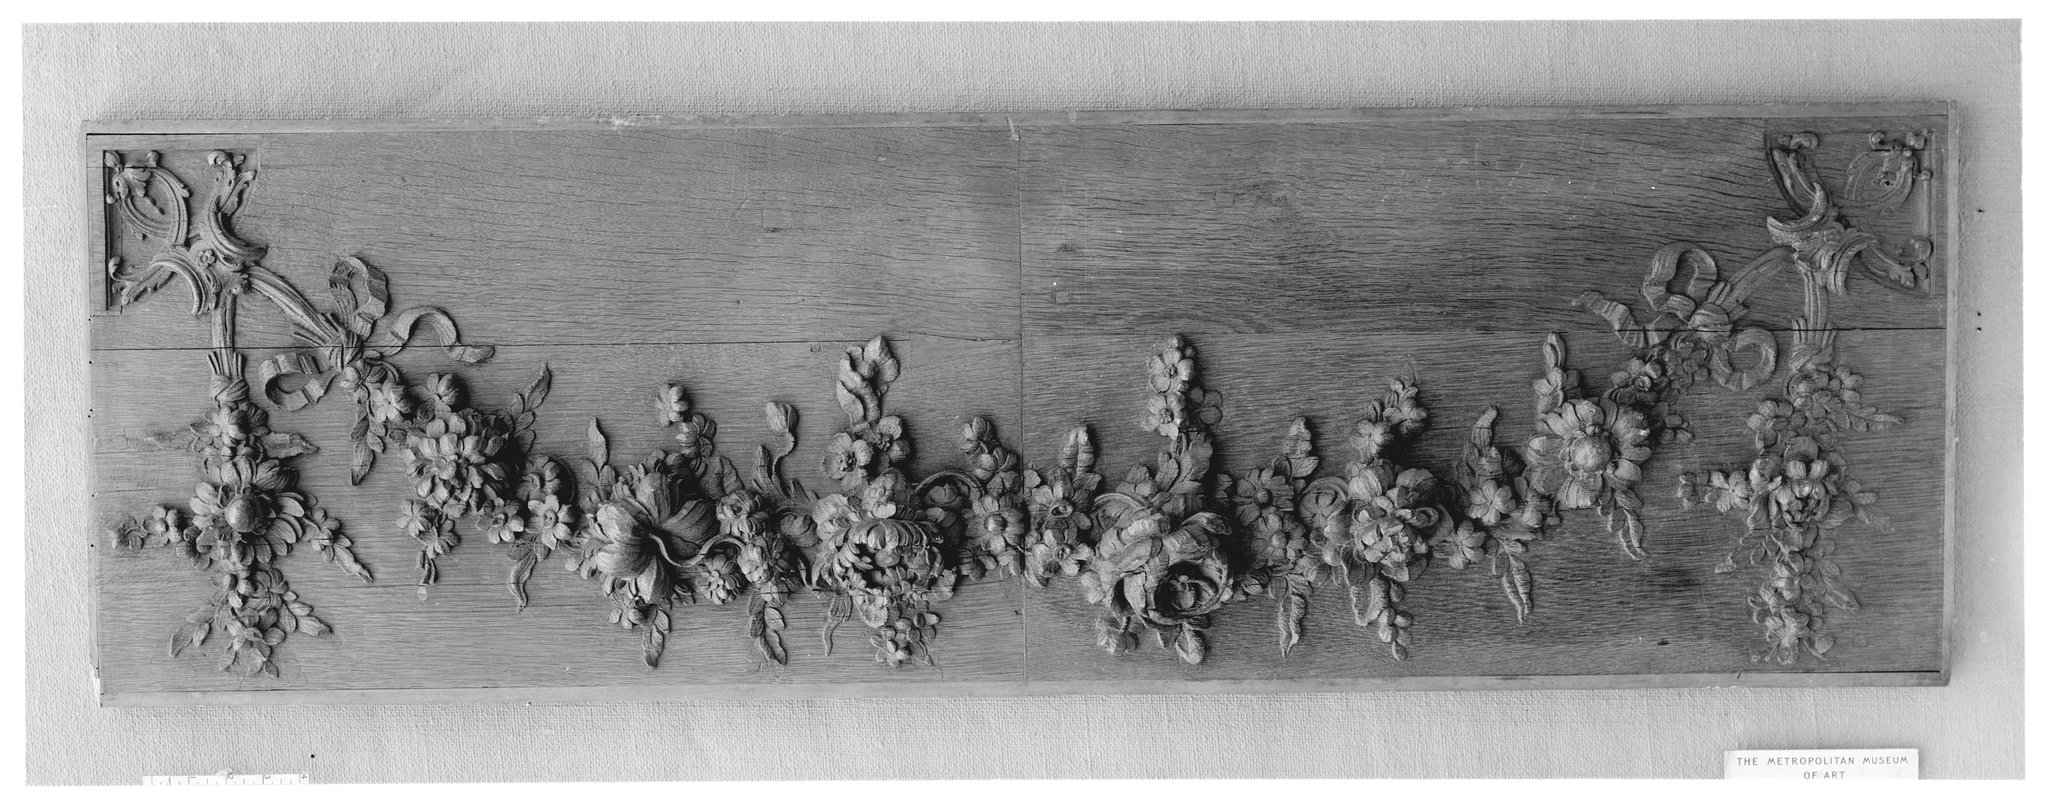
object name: panel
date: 1701-1733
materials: wood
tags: flowers,leaves